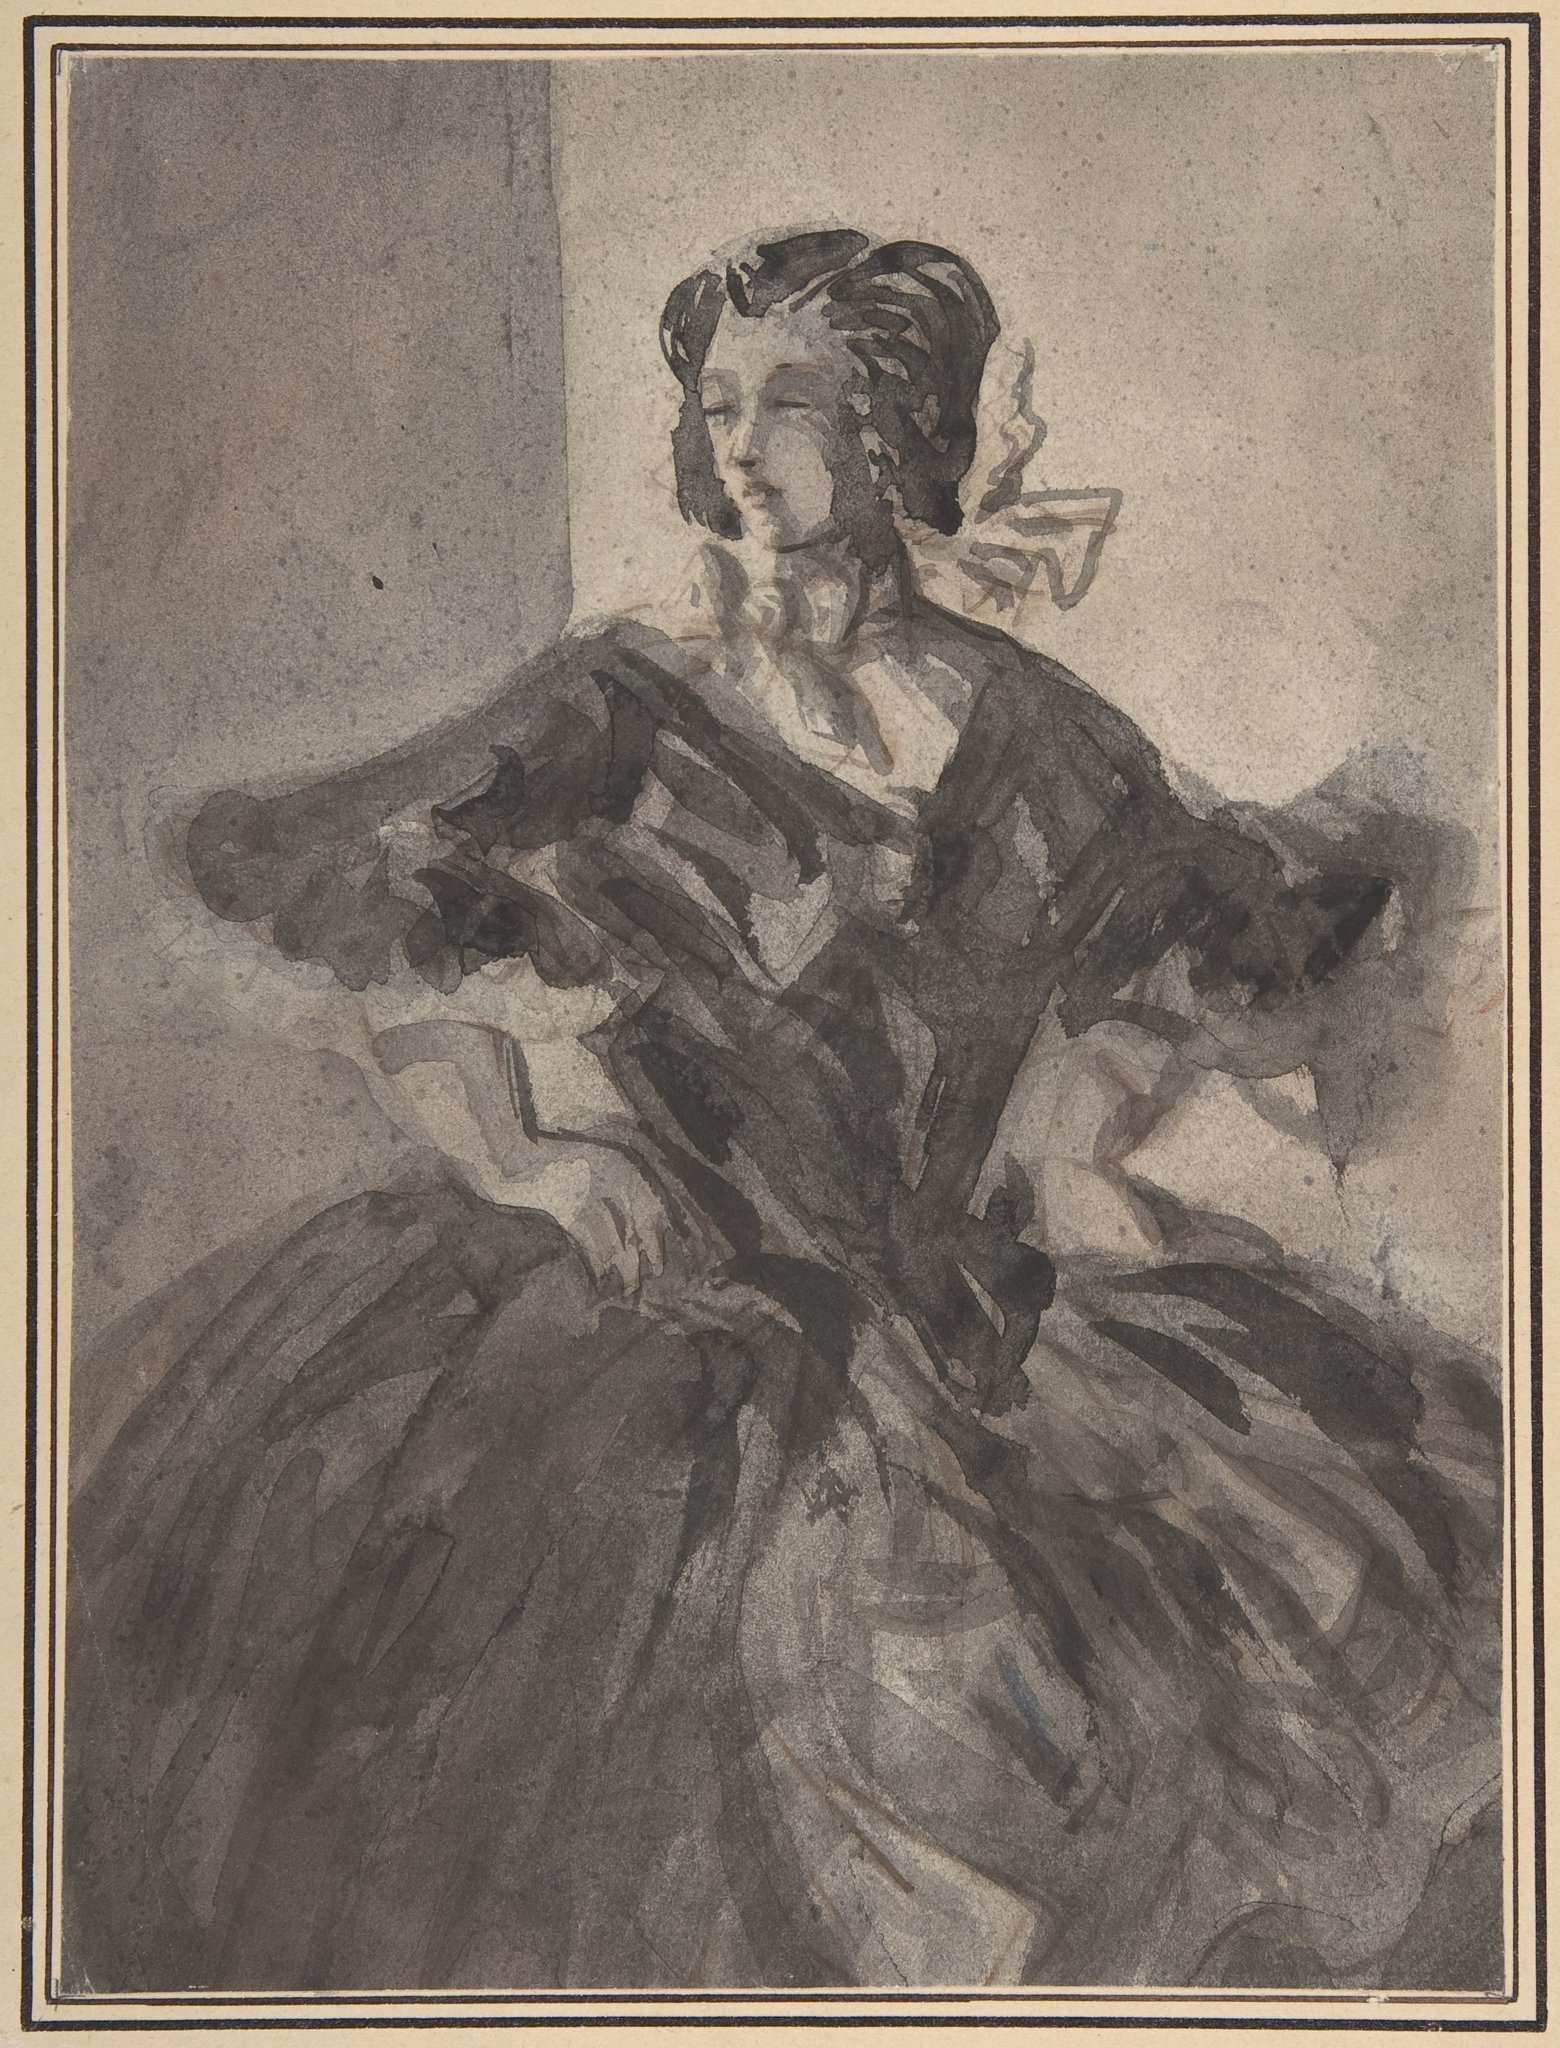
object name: drawing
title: Woman with Arms Akimbo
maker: constantin guys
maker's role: artist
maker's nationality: french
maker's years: 1802-1892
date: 1801-1900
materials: ink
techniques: brush, pen, wash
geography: france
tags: portraits,women